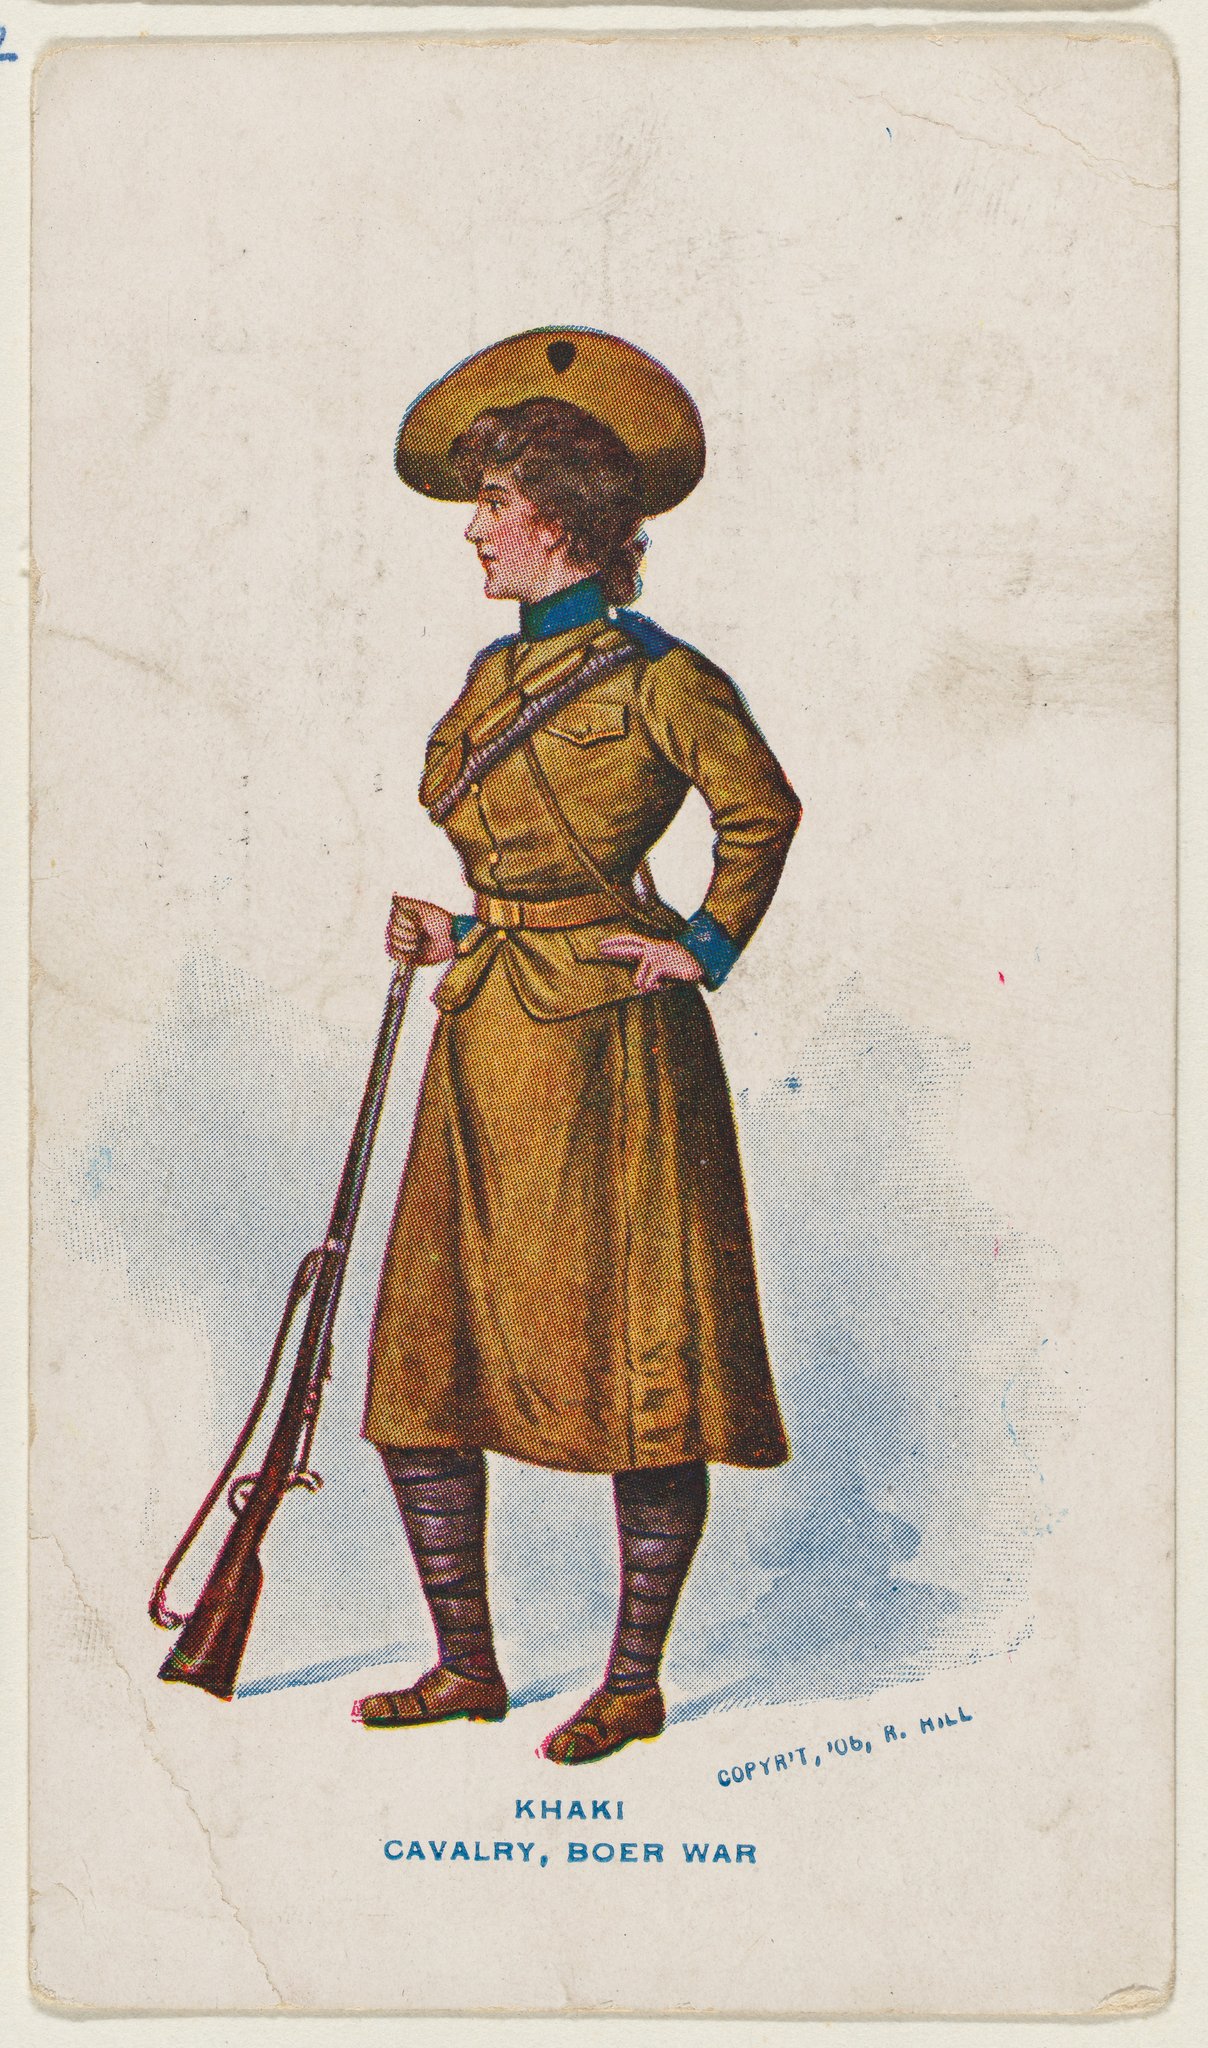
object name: print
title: Khaki, Cavalry, Boer War, from the "Girls and Men in Costume" series (T65), issued with Golden Eagle Cigars by I. Lewis & Co.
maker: i. lewis & co., newark, new jersey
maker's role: publisher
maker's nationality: american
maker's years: 1850-1950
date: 1903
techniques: color lithograph